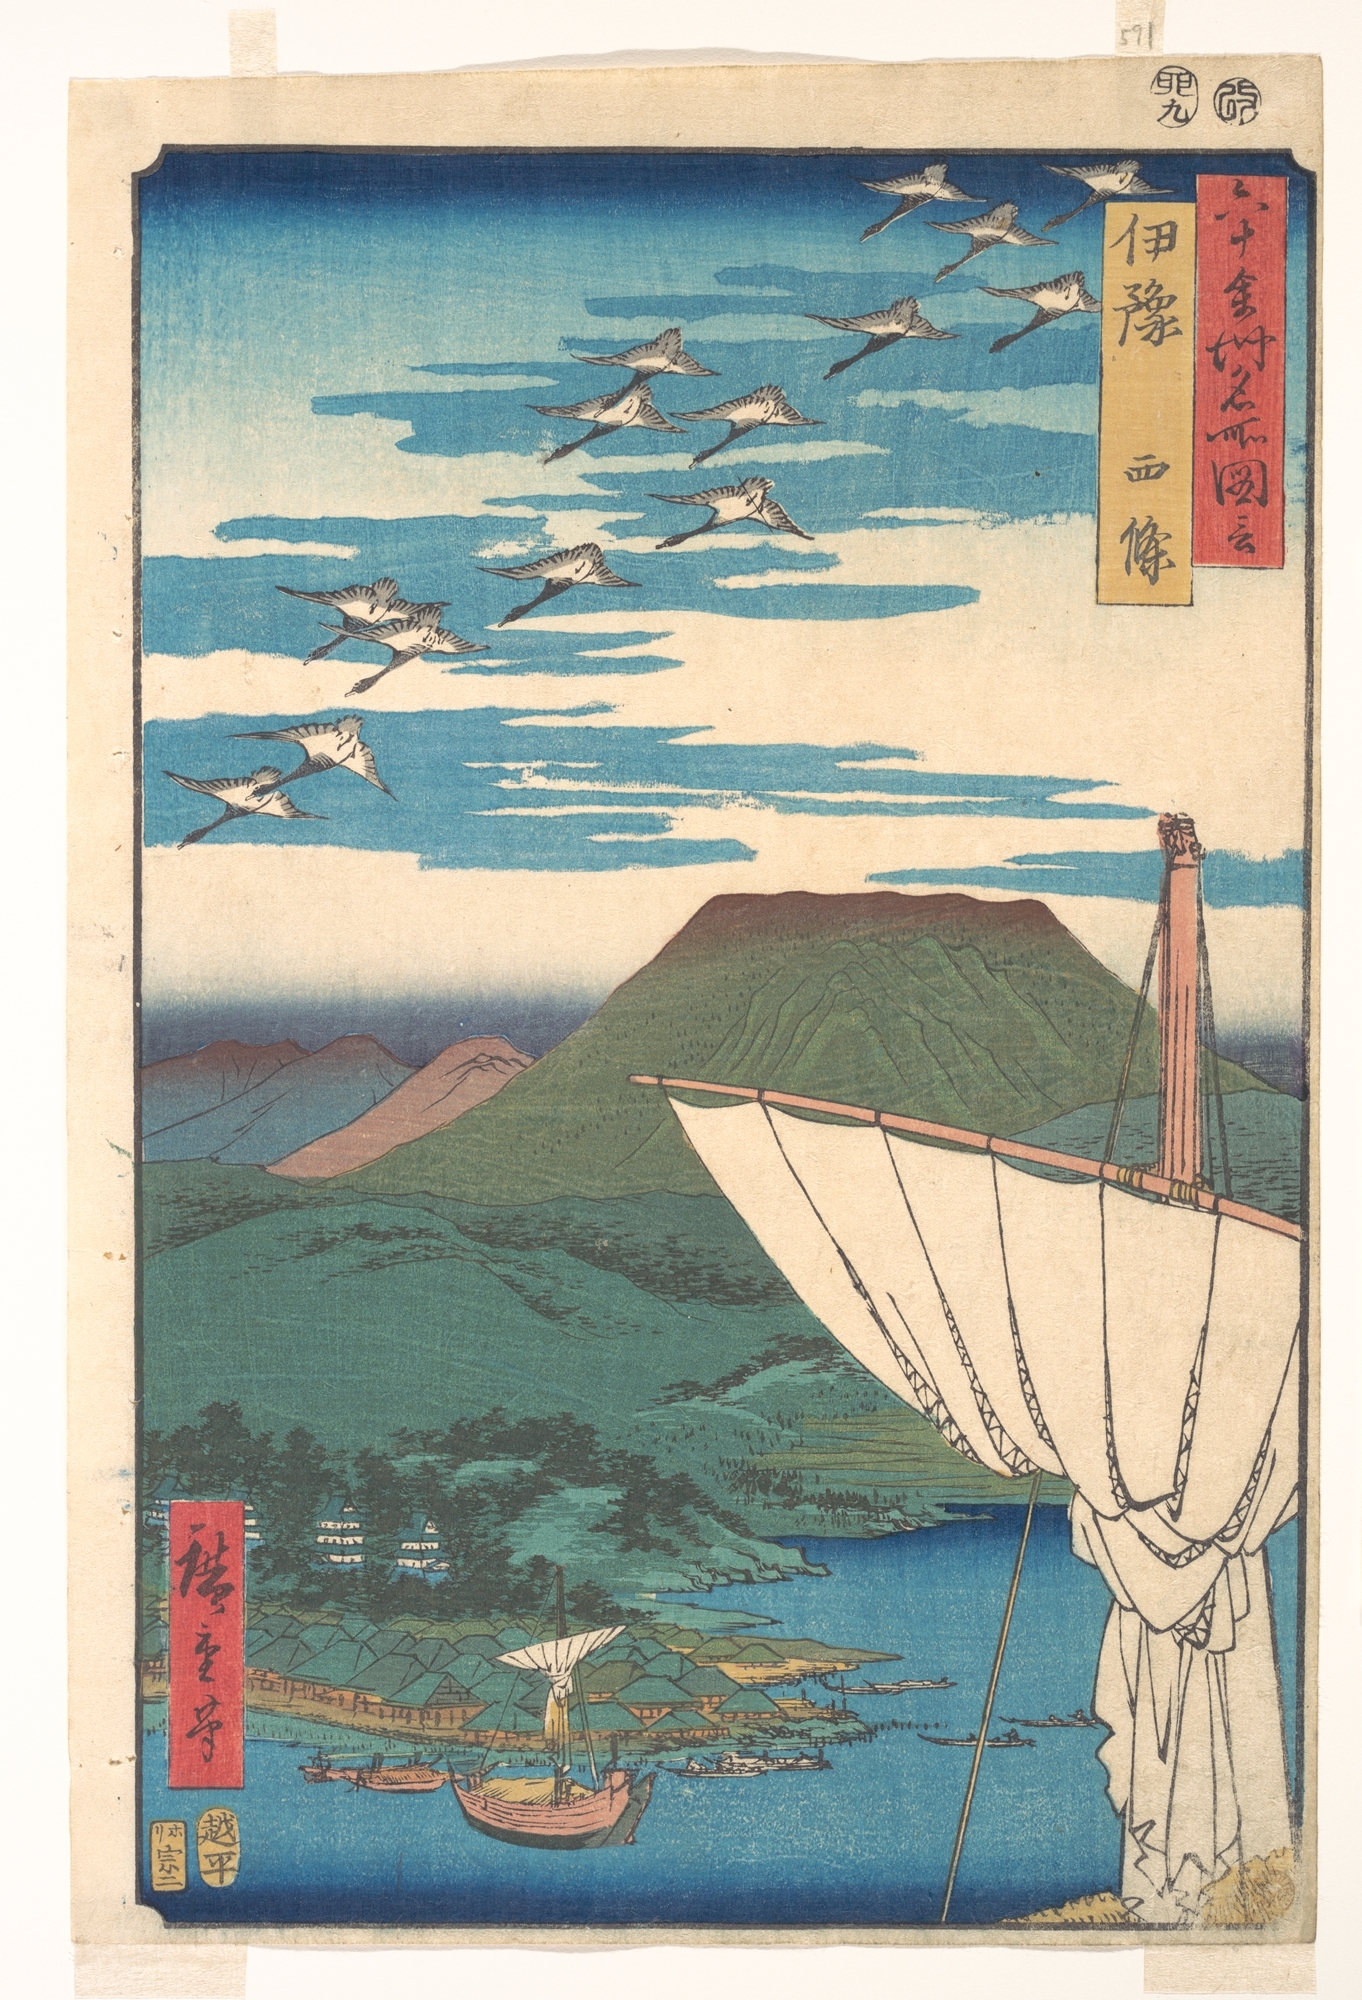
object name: print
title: “Iyo Province, Saijō ,” from the series Views of Famous Places in the Sixty-odd Provinces (Rokujū yoshū meisho zu-e, Iyo, Saijō)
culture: japanese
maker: utagawa hiroshige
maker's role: artist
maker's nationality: japanese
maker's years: 1797-1858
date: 1853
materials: ink, paper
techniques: woodblock print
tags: birds,mountains,boats